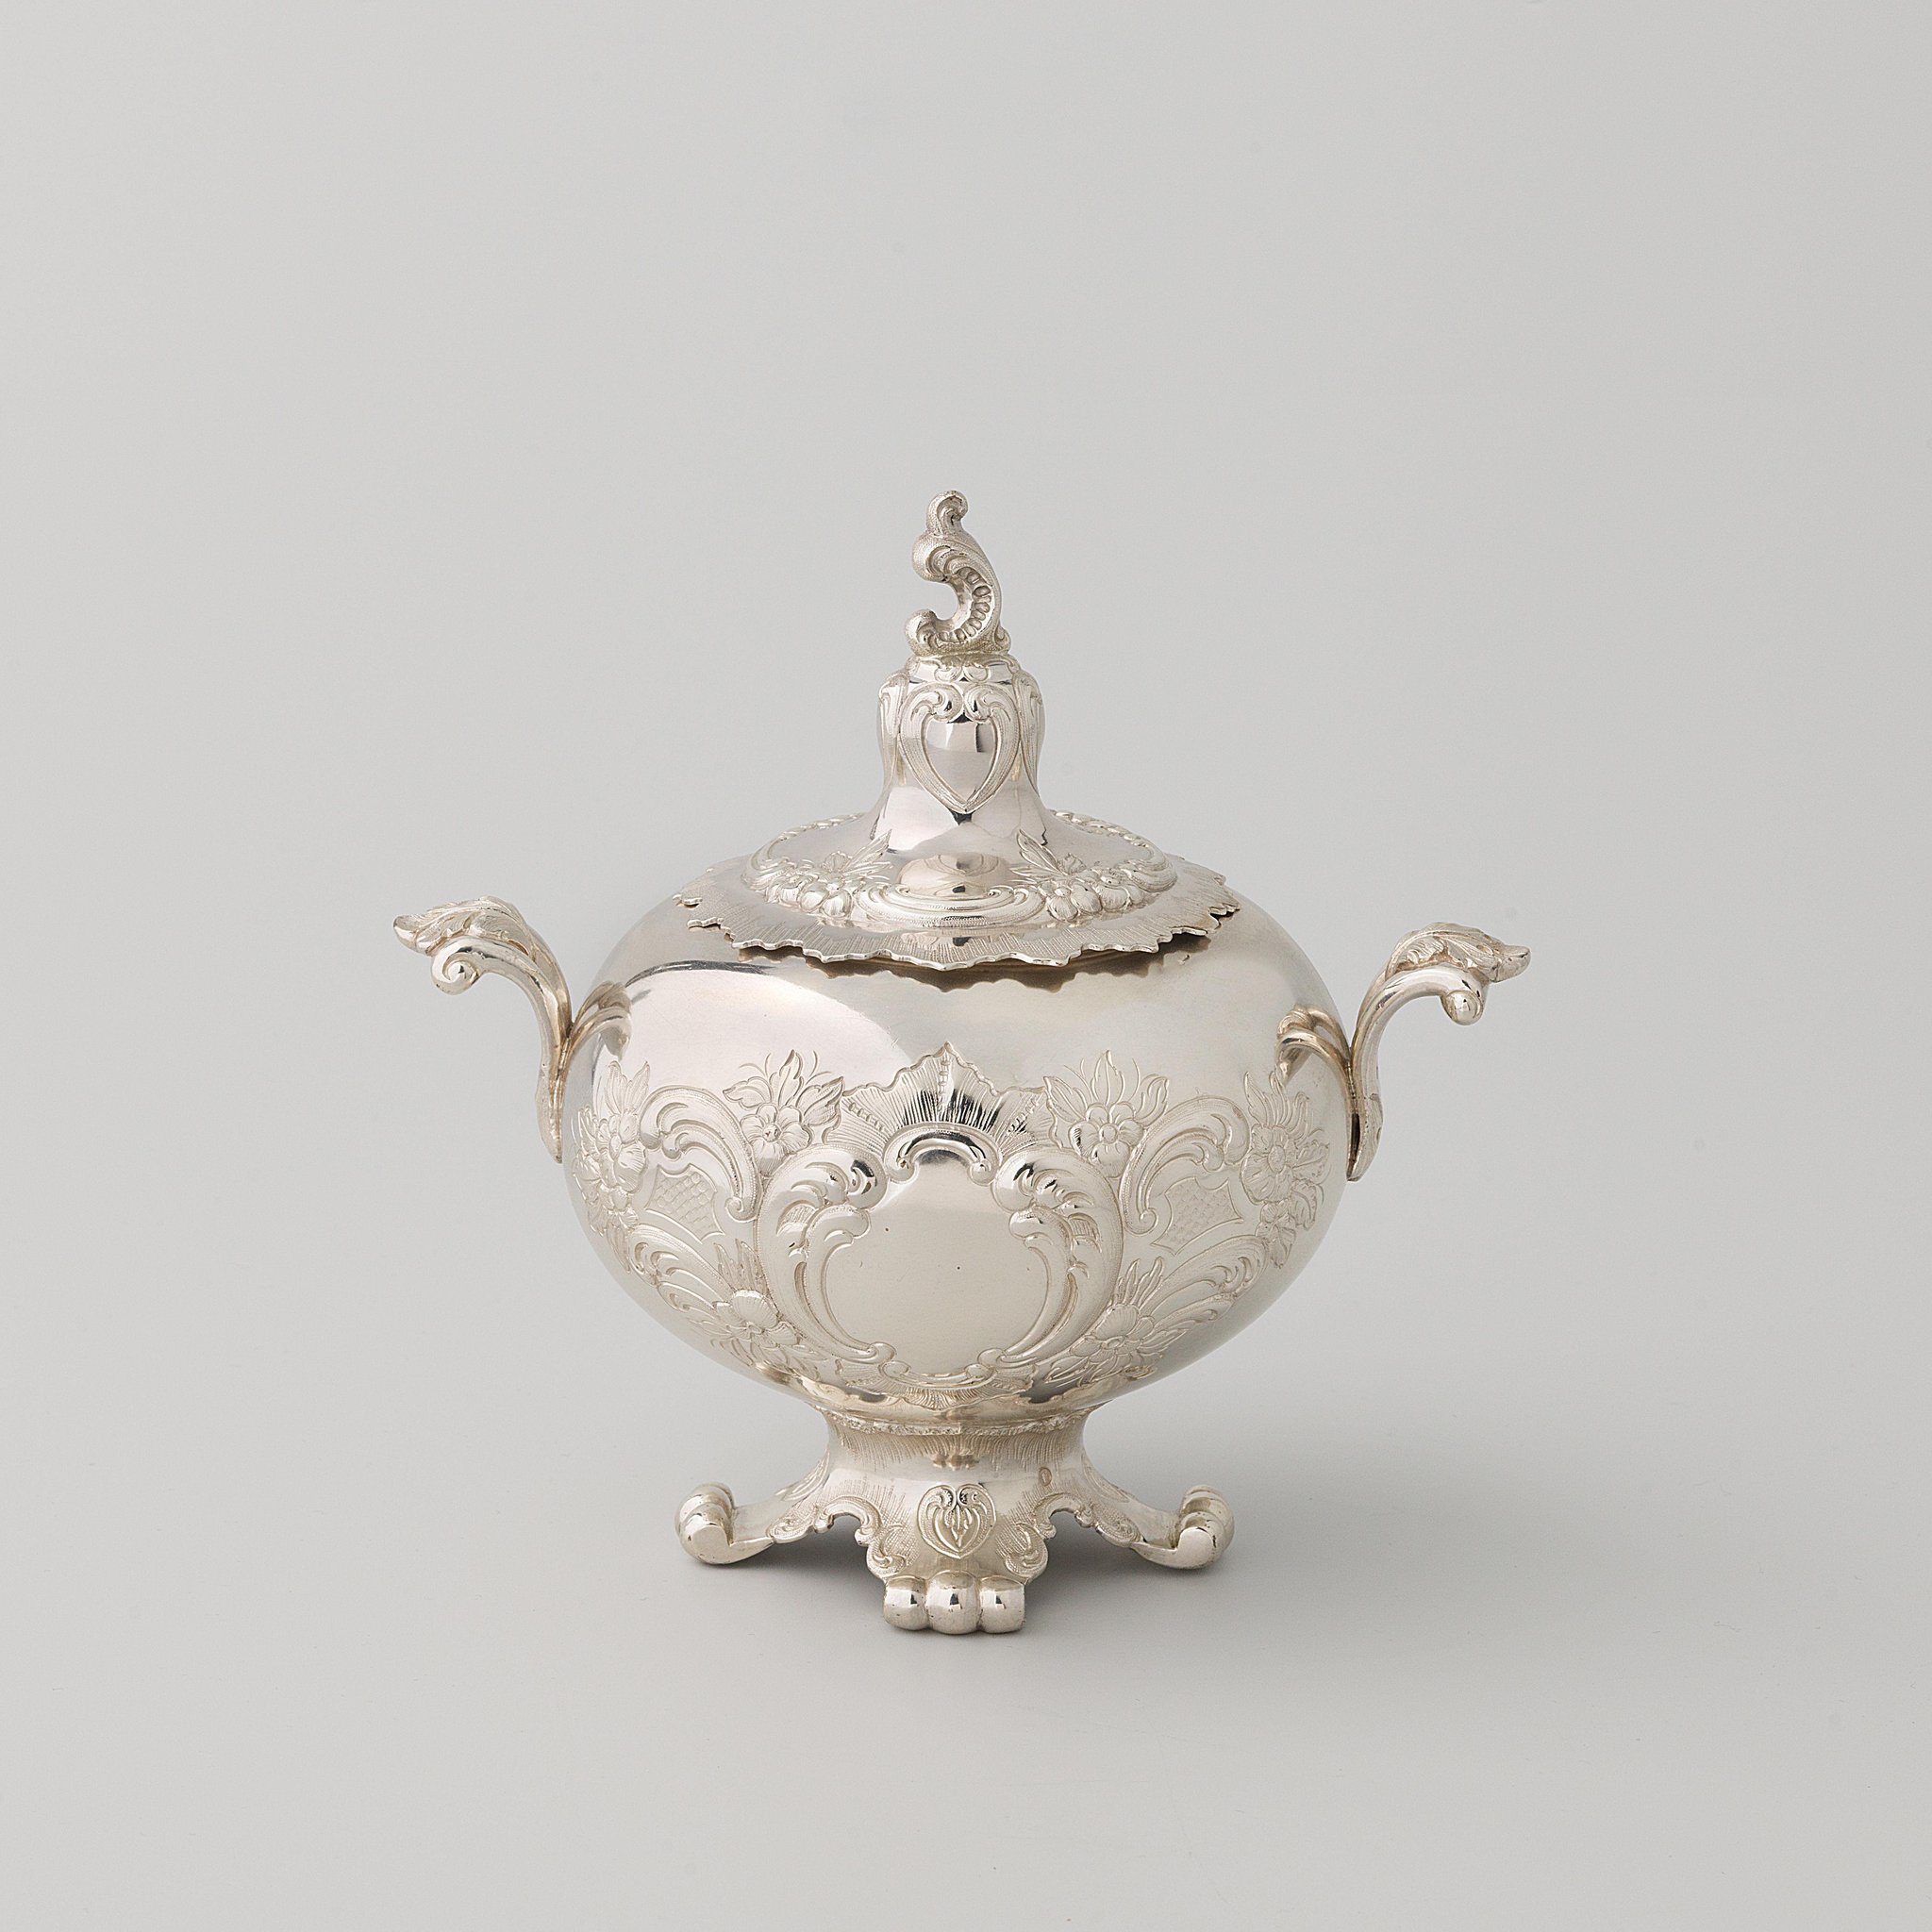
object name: tea service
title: Klontjespot met drijfwerk en gravering in Louis XV stijl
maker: daniel jan de haas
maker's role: silversmith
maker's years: 1821-1886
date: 1865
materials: silver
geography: amsterdam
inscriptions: date letter: ‘F’, alloy mark, assay office mark, maker's mark, retailer's mark: ‘A.D. VERSCHUUR’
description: Coffee pot and four-piece tea service. Silver and ivory. Amsterdam, 1863, 1865, by Daniel Jan de Haas, designed by A.D. Verschuur